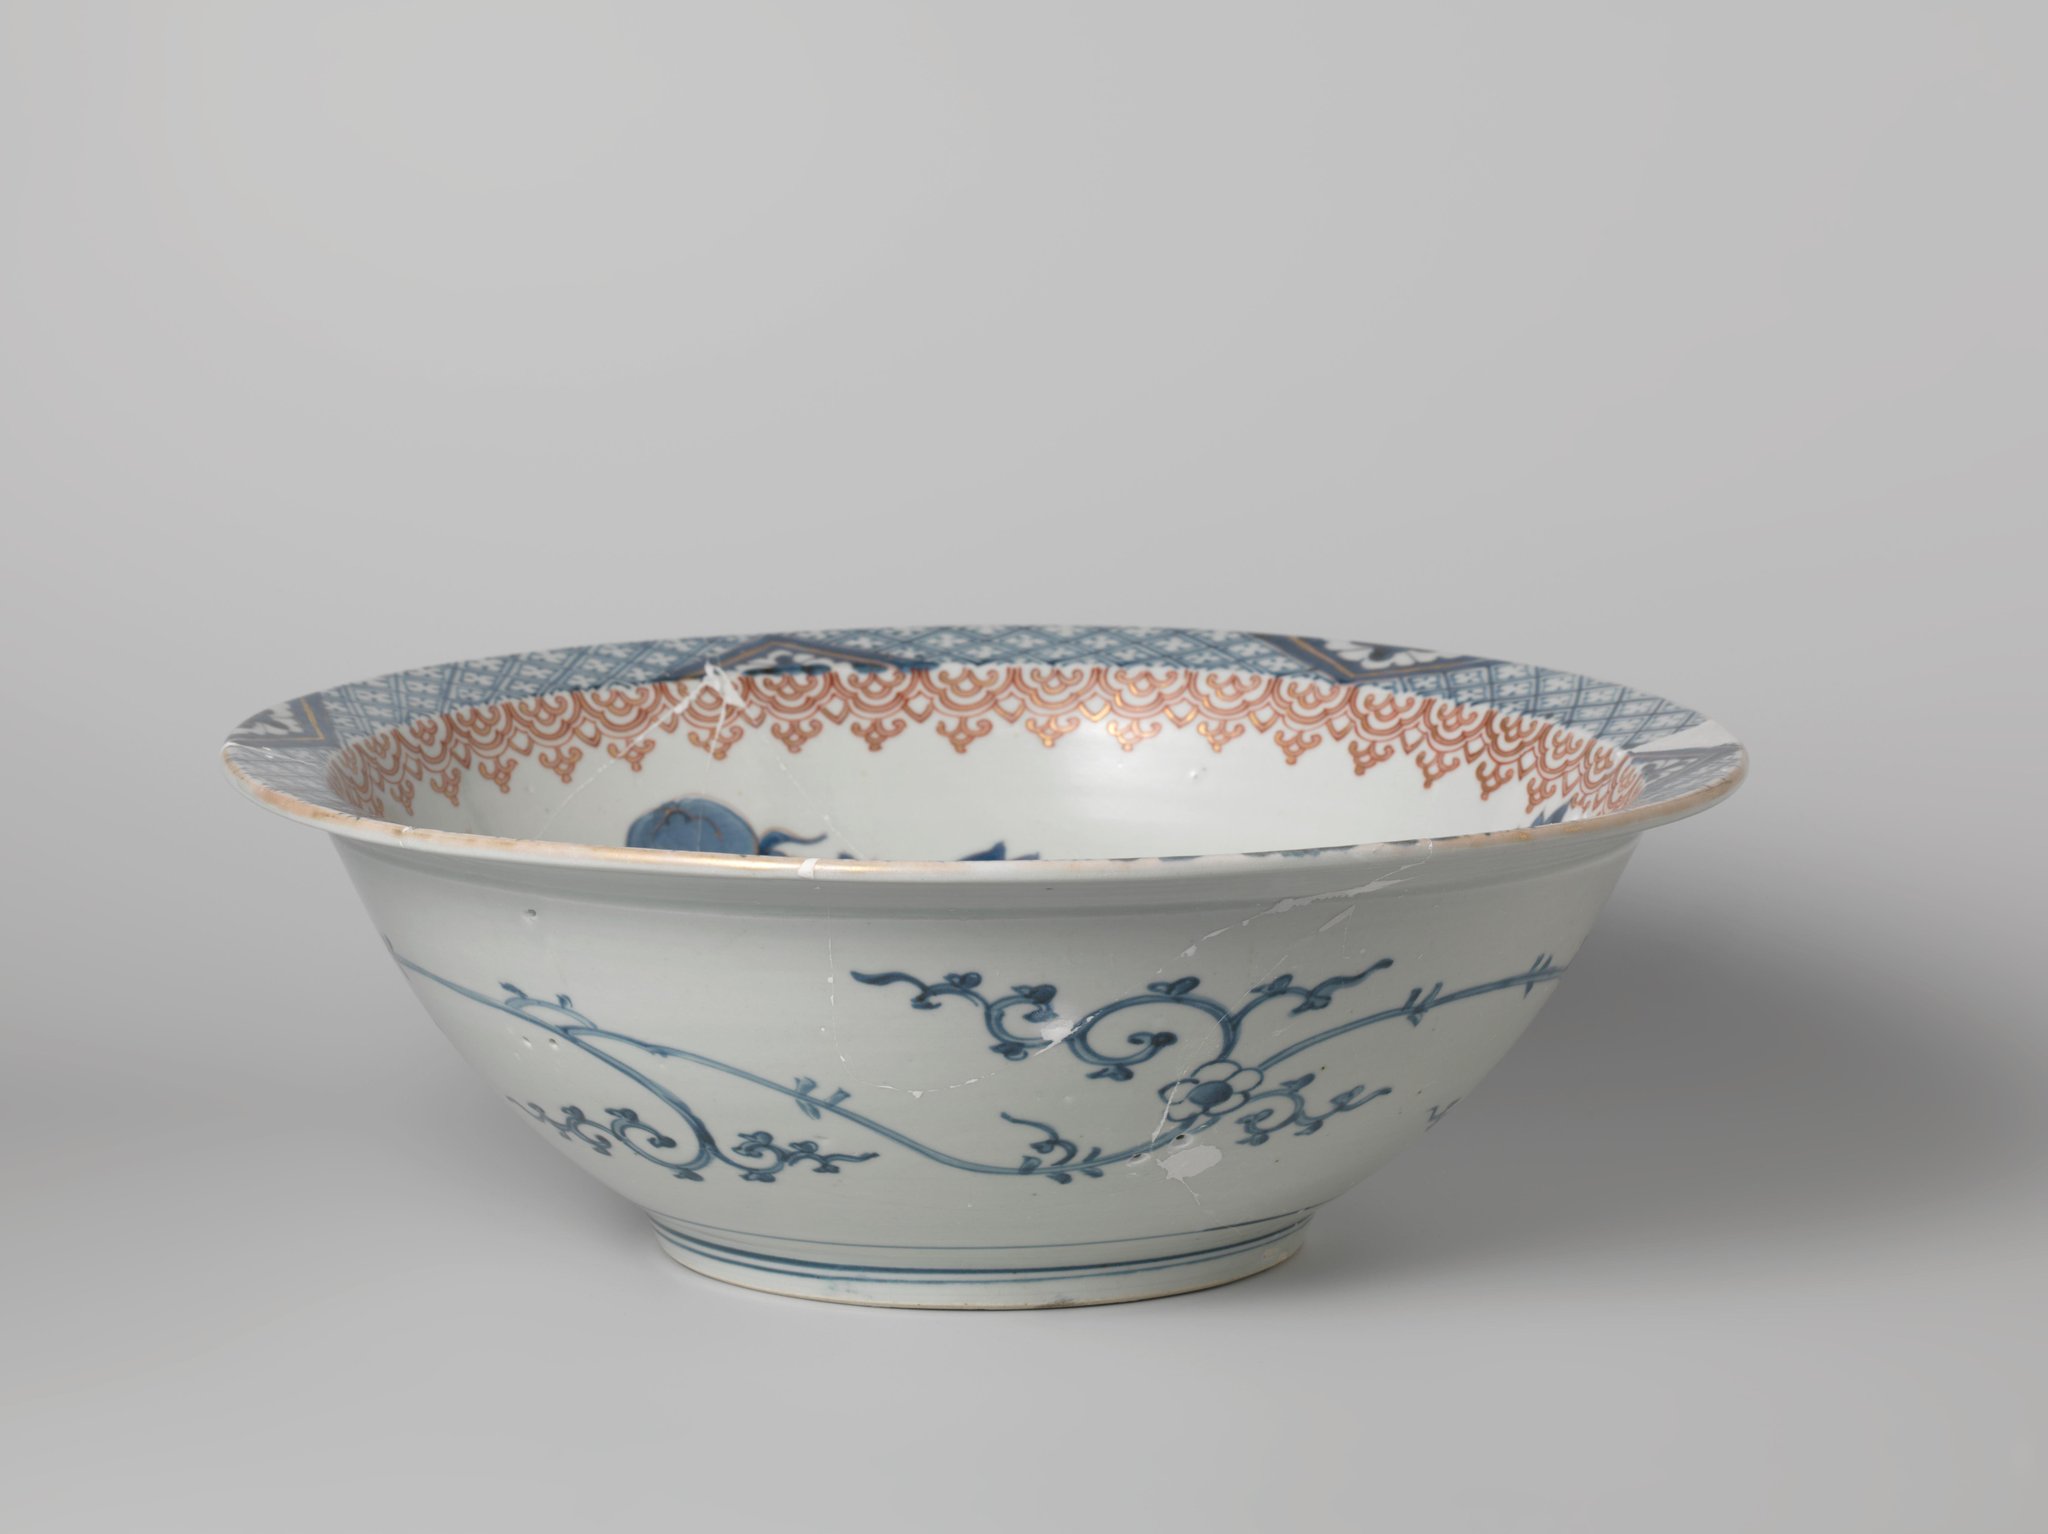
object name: bowl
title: Bowl with shishi and butterfly near a peony branch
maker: Anonymous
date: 1675-1725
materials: cobalt, glaze, gold, paint, porcelain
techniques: firing, gilding, turning, vitrification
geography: japan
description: Grote kom van porslein met een platte rand, beschilderd in onderglazuur blauw en op het glazuur rood en goud. De binnenzijde met een shishi (leeuwhond) en een vlinder bij een pioentak; de wand met een band met ruyi-motieven. De binnenrand met servetwerk onderbroken door driehoeken met een uitgespaarde, gestileerde bloem. Op de buitenwand een doorlopende bloemrank. De kom is gebroken geweest. Imari.